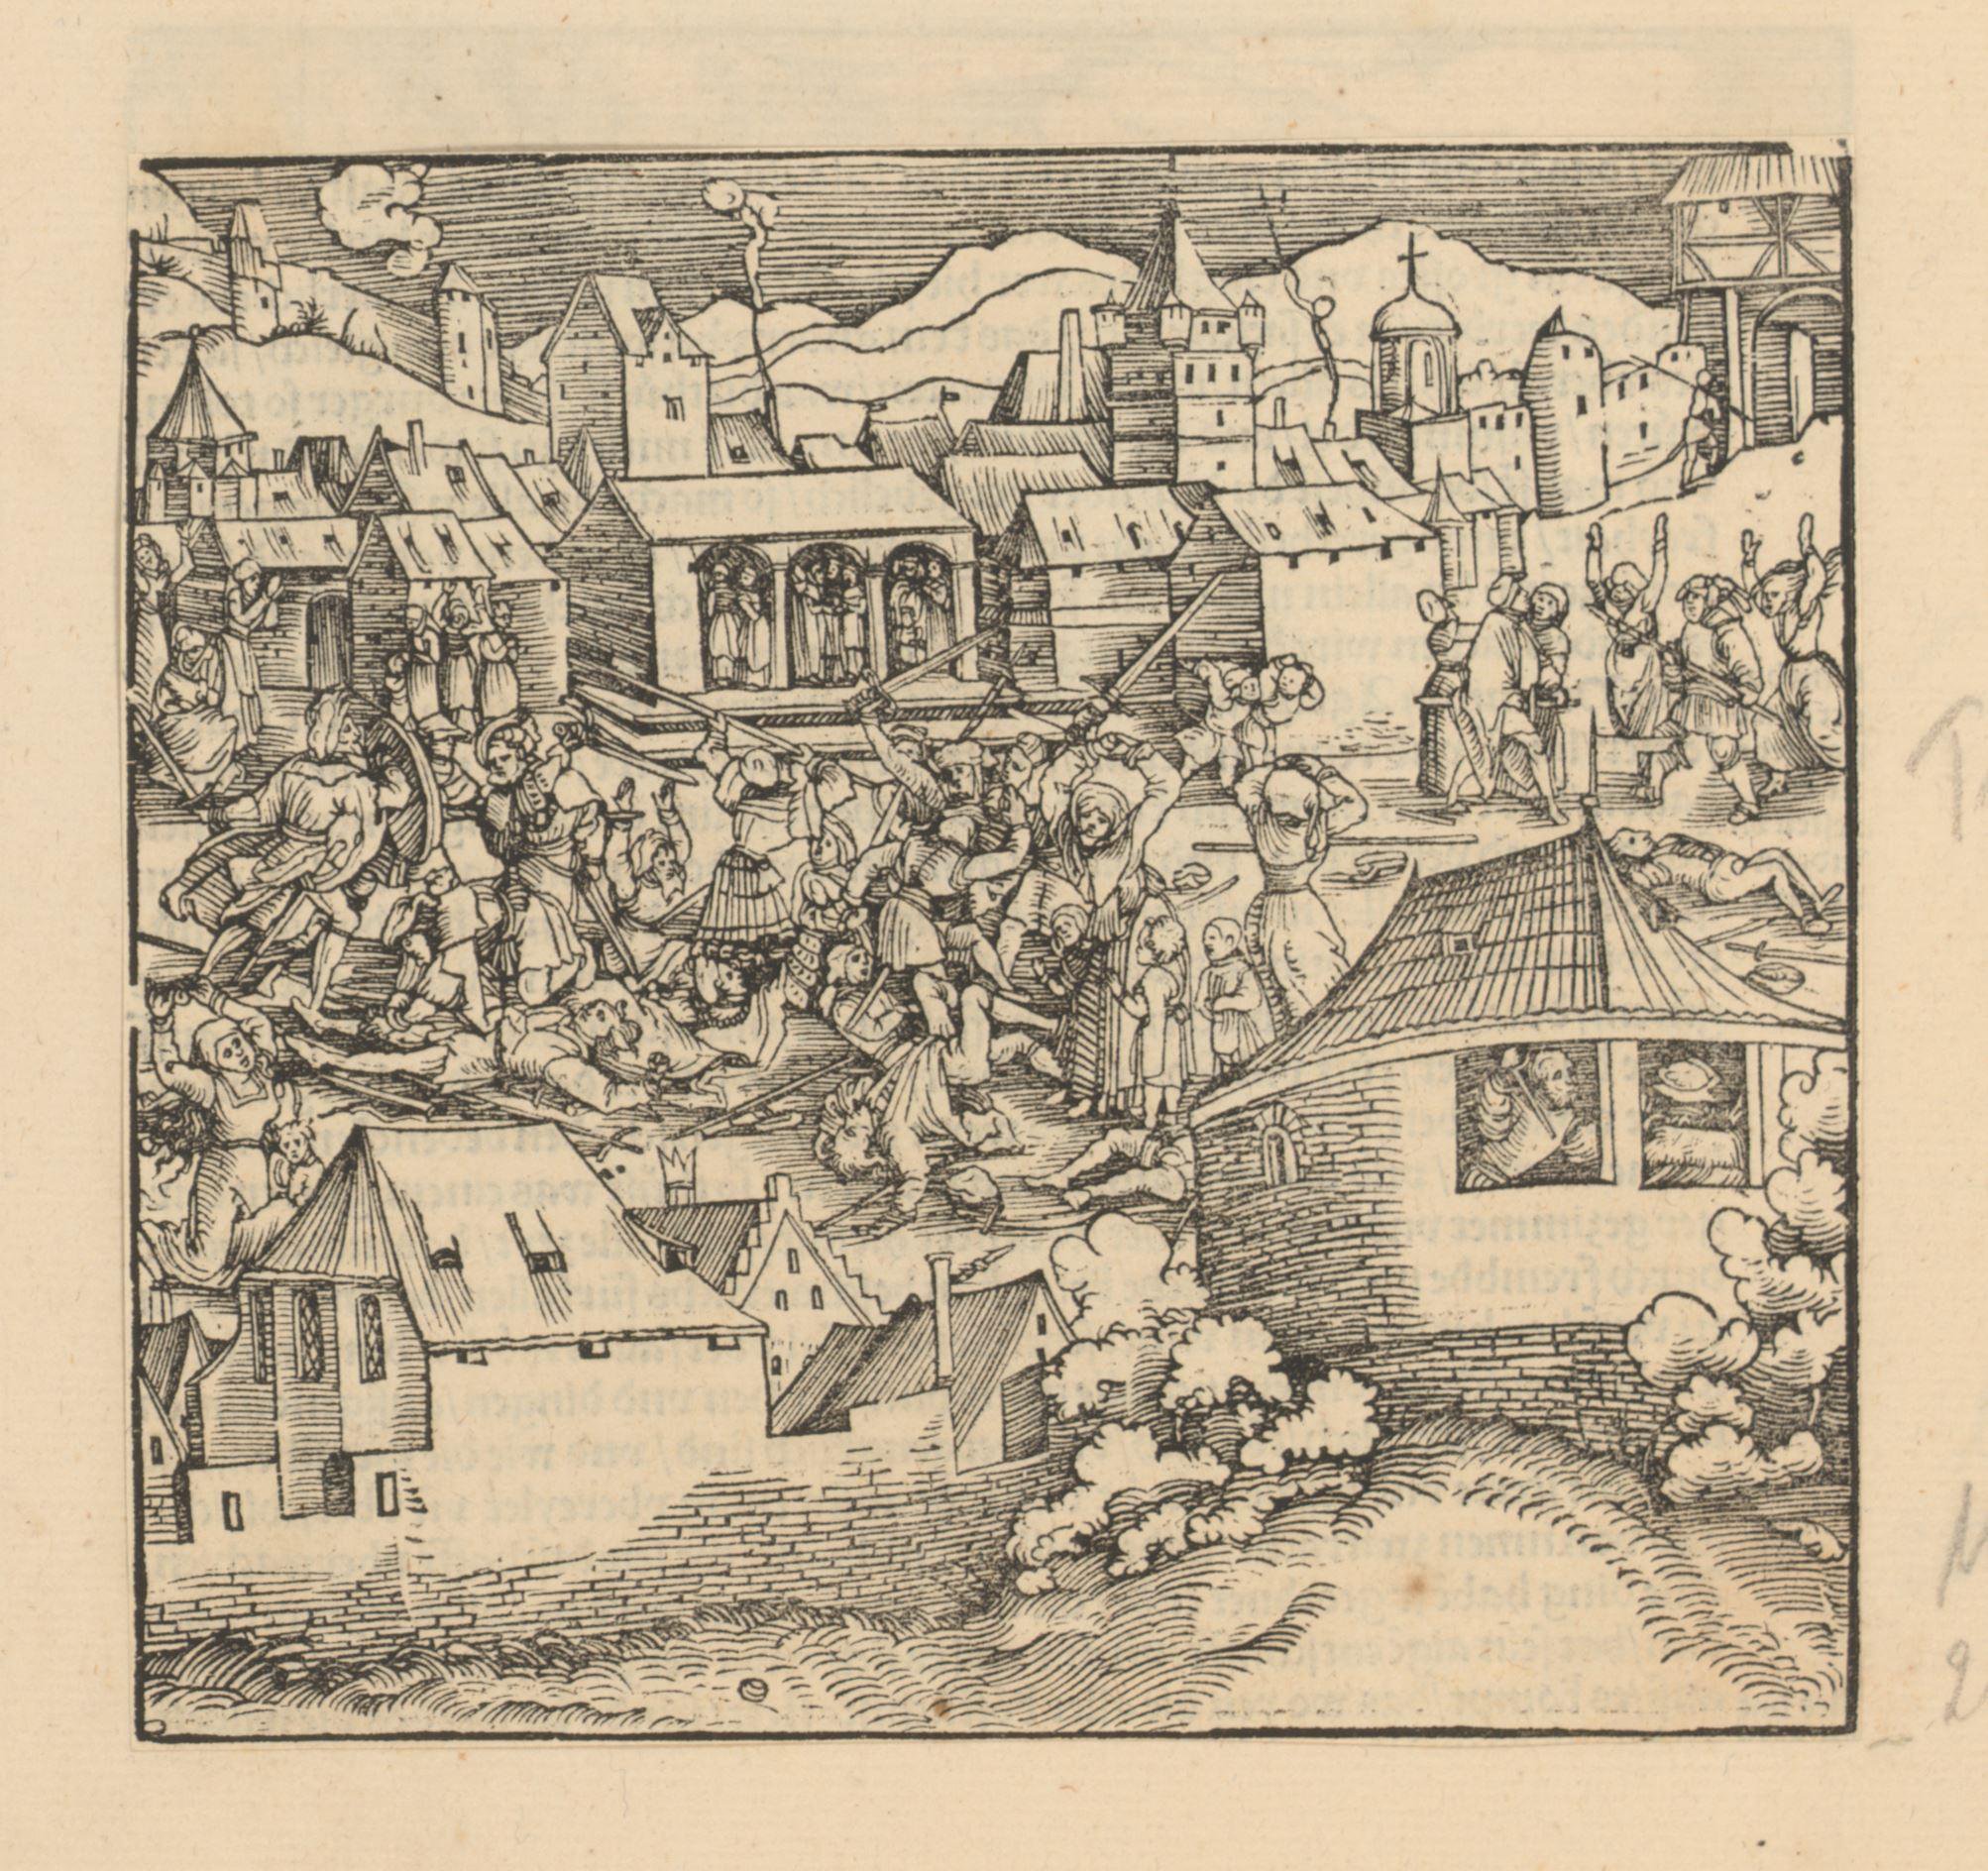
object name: book illustration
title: Vechtende mensen in een stad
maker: Anonymous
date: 1514-1532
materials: paper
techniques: letterpress printing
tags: hand-to-hand fighting (~ battle), occupation ~ war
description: Deze prent is gebruikt in: Petrarca, Francesco. Von der Artzney bayder Glück, des guten und widerwertigen: unnd weß sich ain yeder inn Gelück und Unglück halten sol (...). Augsburg: Heinrich Steiner, 1532. Deze uitgave is ook bekend onder de titel 'Trostspiegel in Glück und Unglück'.